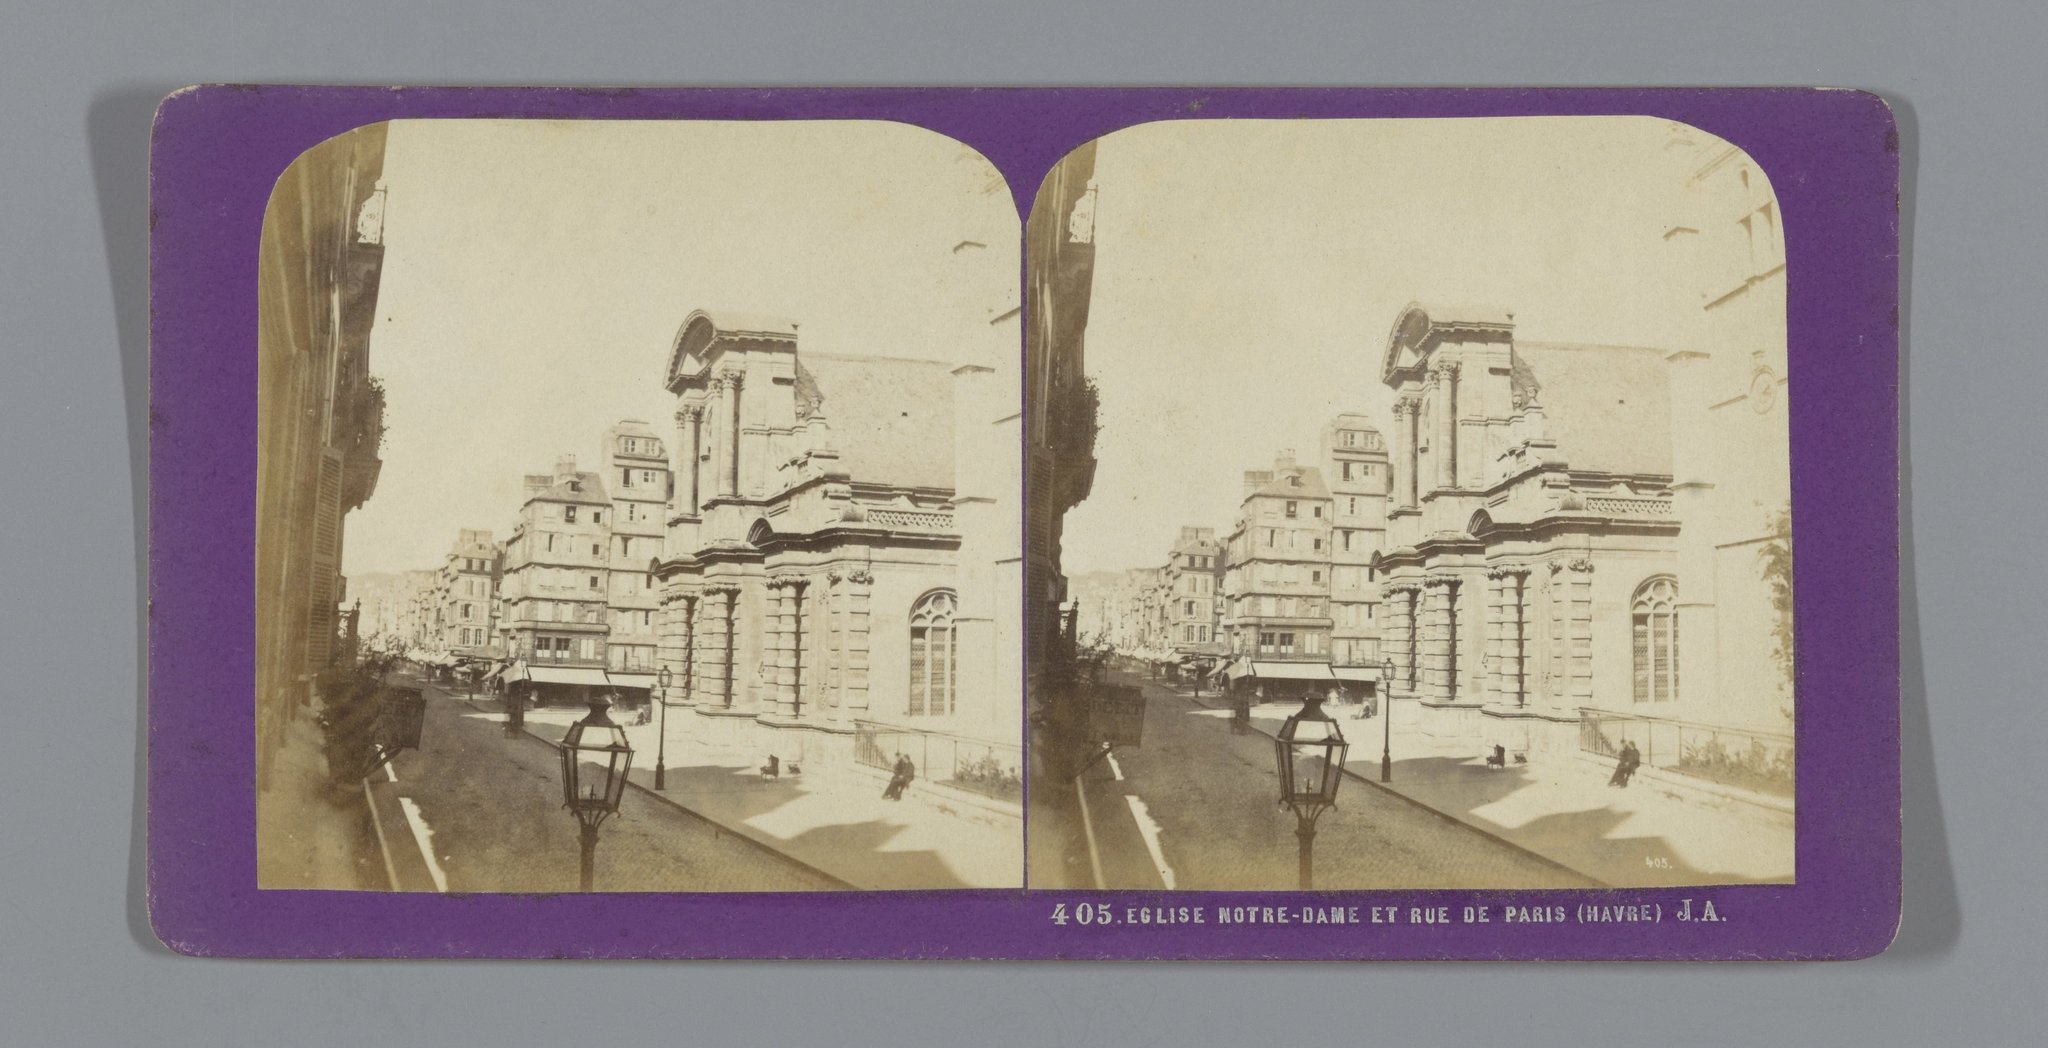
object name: stereograph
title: Eglise Notre-Dame et Rue de Paris (Havre)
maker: jean andrieu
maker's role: fotograaf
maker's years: 1816-1872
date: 1862-1876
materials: cardboard, photographic support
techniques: albumen print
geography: le havre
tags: façade (of house or building)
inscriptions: number: ‘405.’